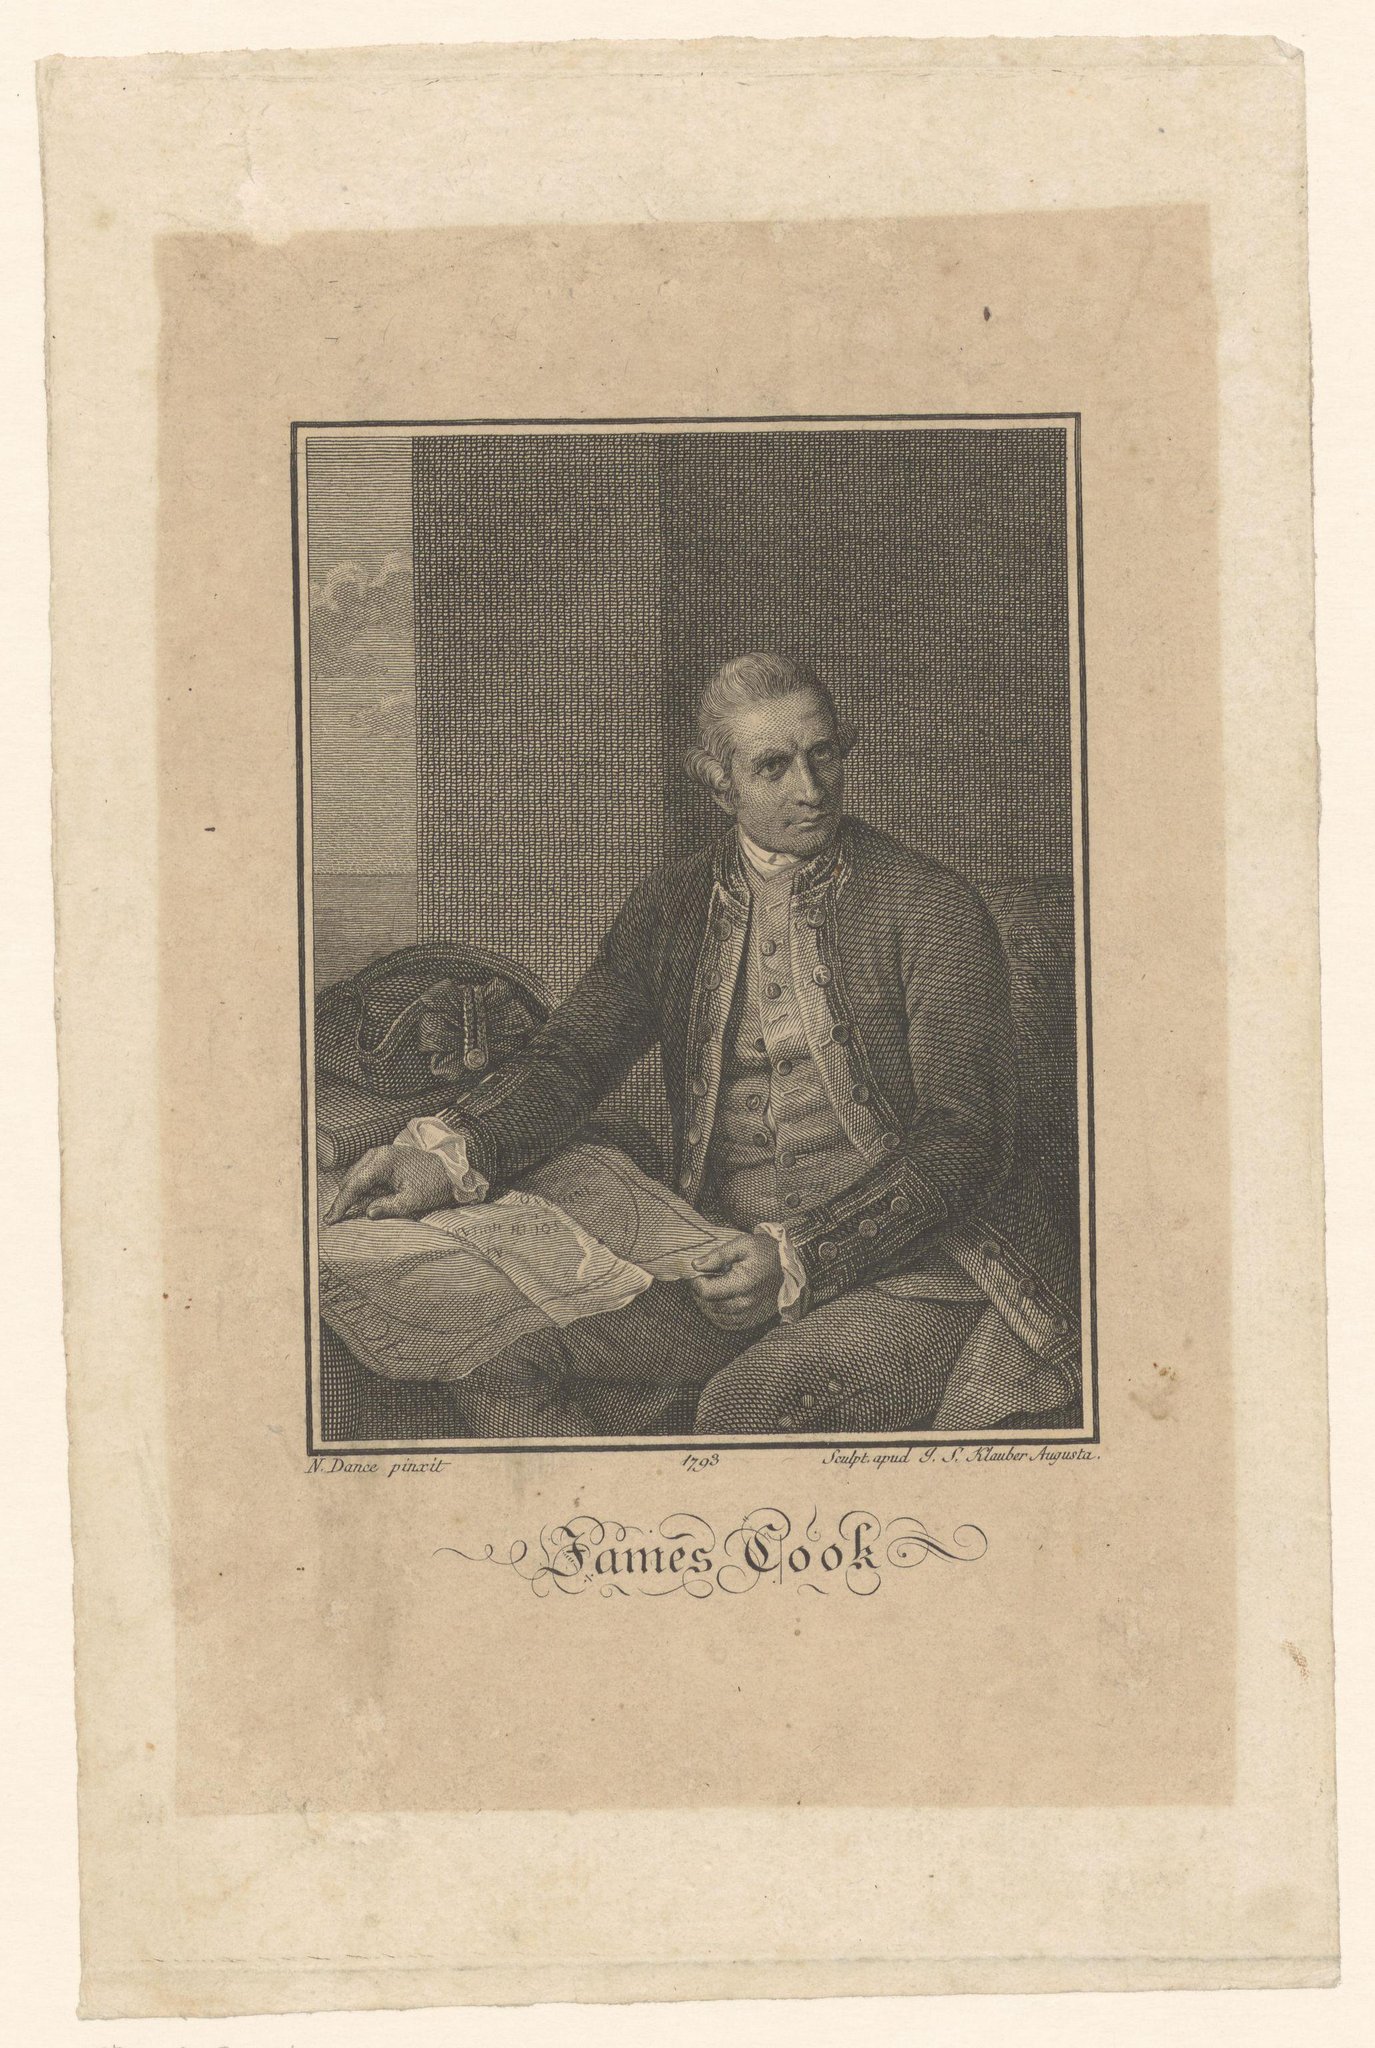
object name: print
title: Portret van James Cook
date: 1793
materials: paper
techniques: engraving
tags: james cook, historical persons, seaman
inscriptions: collector's mark: Lugt 2228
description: Het schilderij uit 1775 door Nathaniel Dance waarop deze prent is gebaseerd bevindt zich in National Maritime Museum, te Greenwich, Londen.